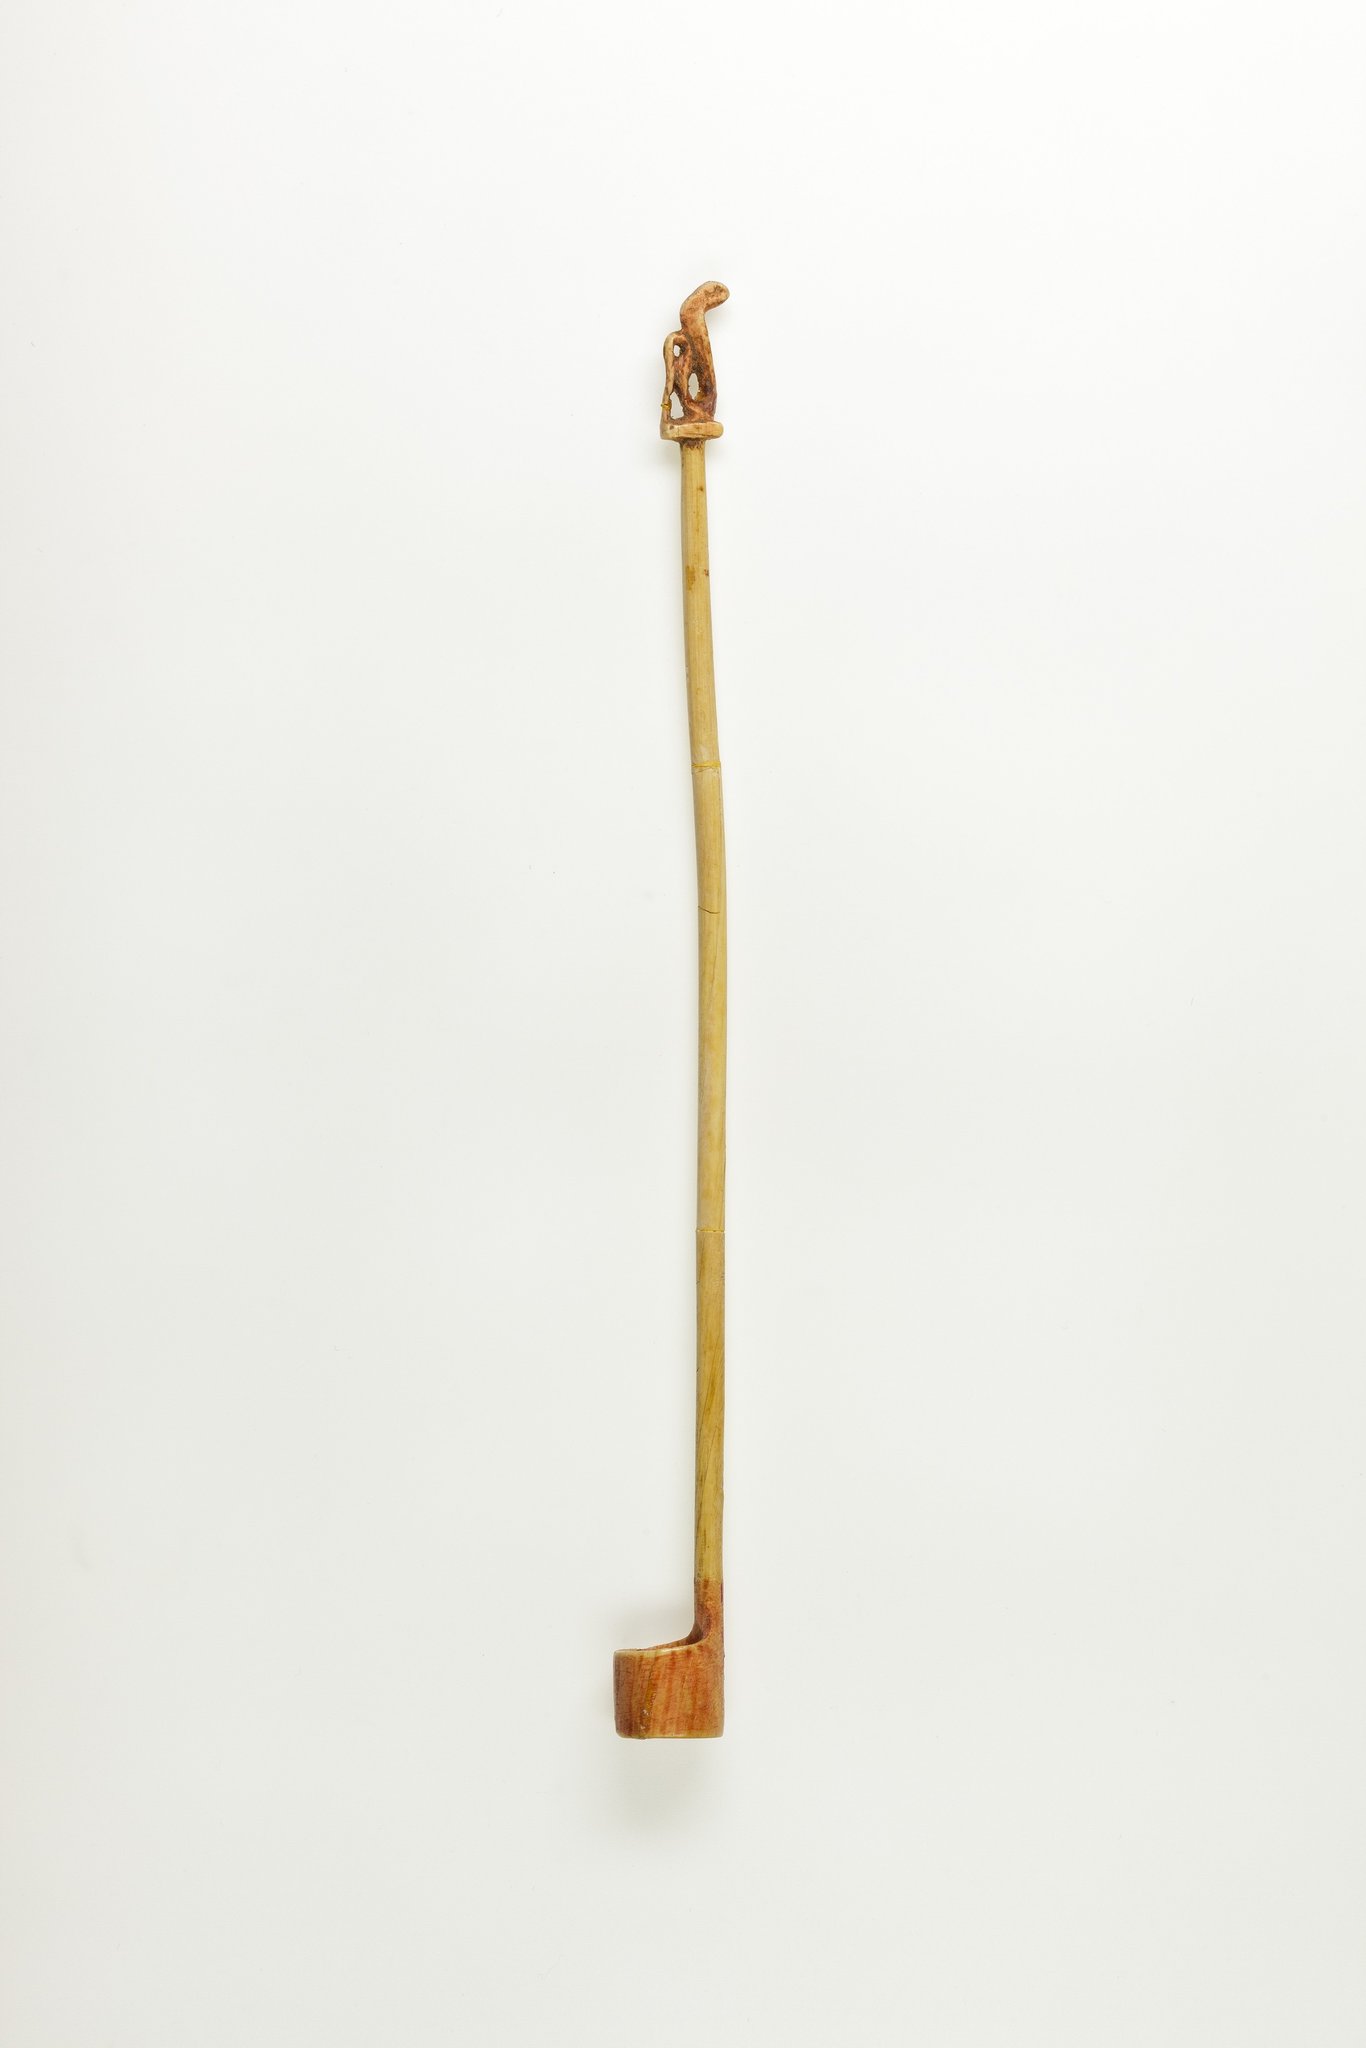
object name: cosmetic spoon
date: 1550-1295 BCE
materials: ivory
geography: upper egypt